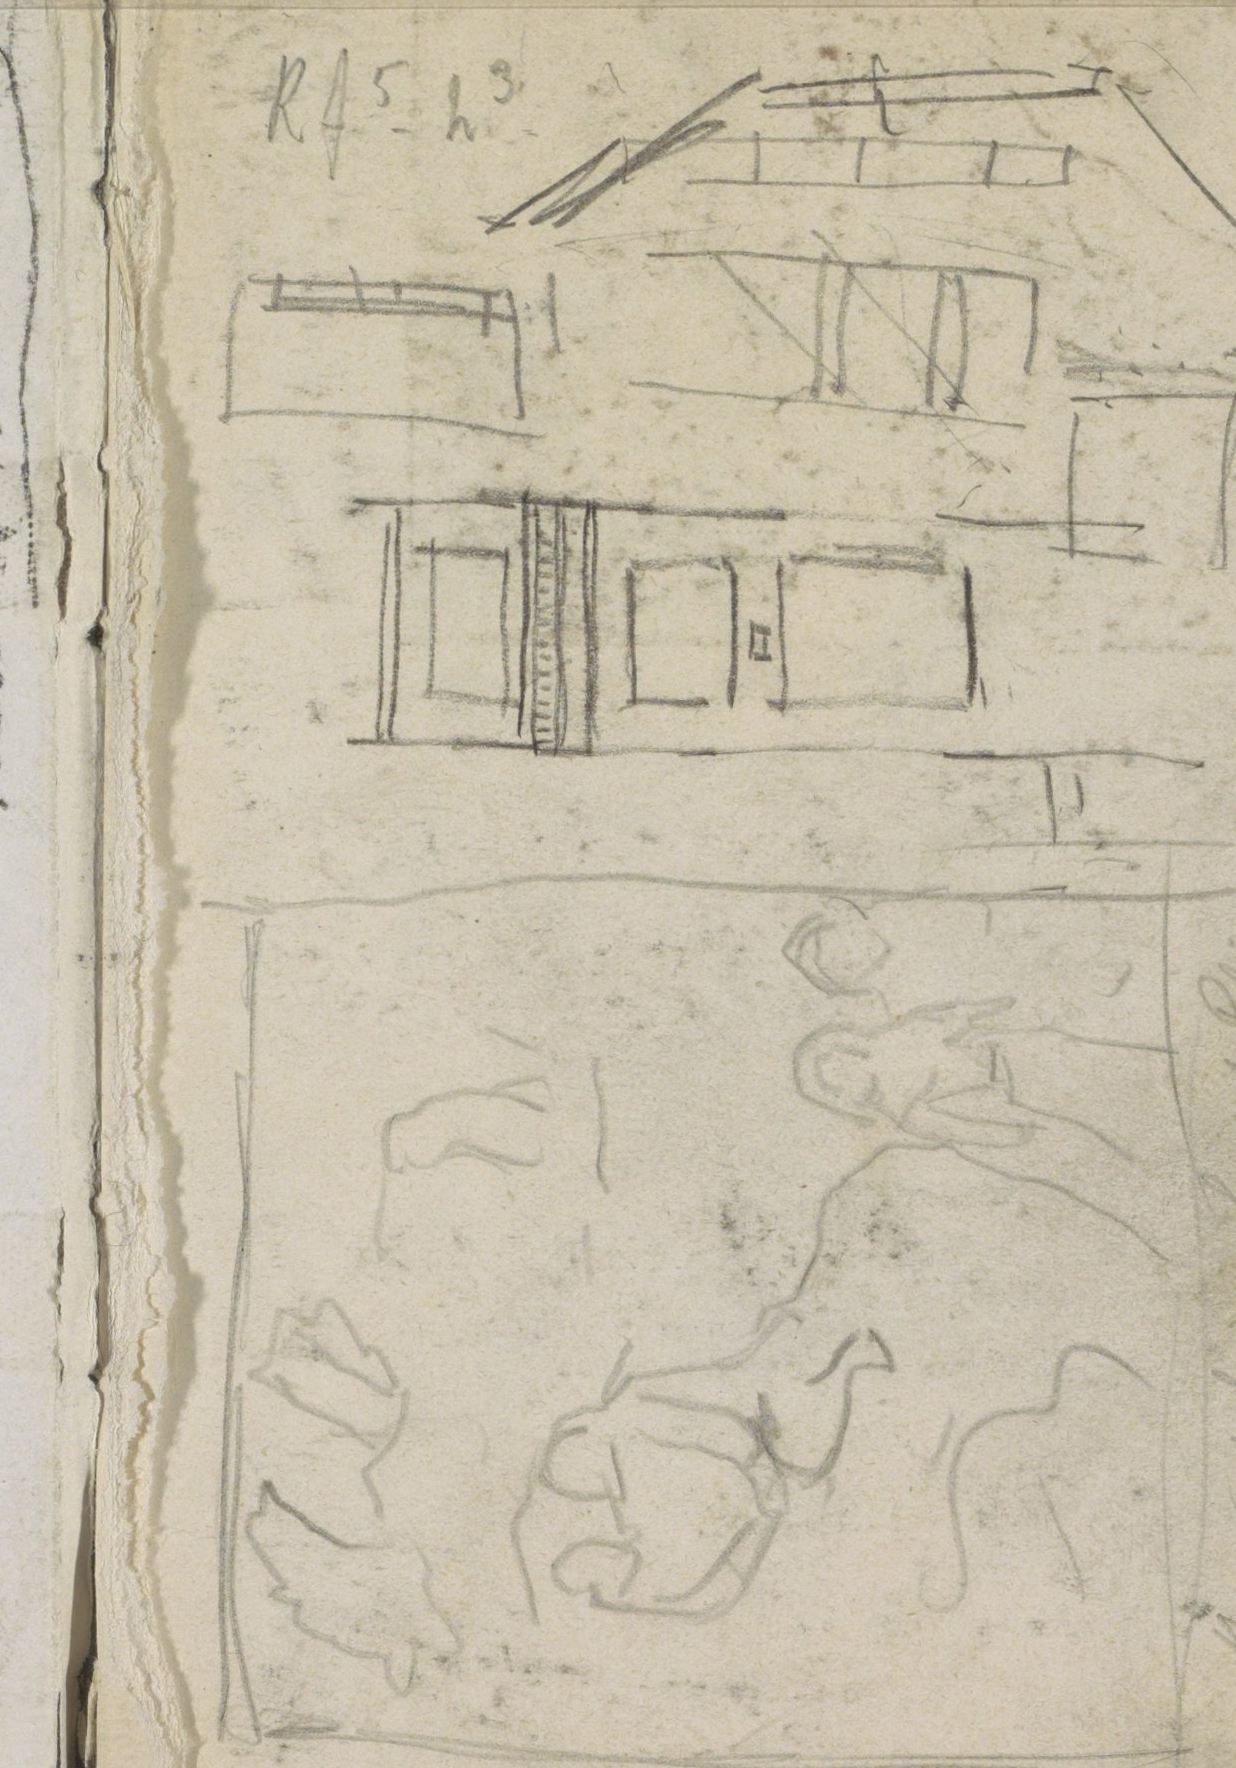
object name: sketchbook leaf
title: Architectuurstudies en een reliëf uit een huis aan het Leidsplein te Amsterdam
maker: george hendrik breitner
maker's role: draughtsman, painter, print maker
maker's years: 1857-1923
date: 1900-1923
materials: chalk, paper, pencil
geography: amsterdam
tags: piece of sculpture, reproduction of a piece of sculpture (+ stone ~ arts), architectural detail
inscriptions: annotation: ‘Steen in de huisjes Leidsche Plein’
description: Architectuurstudies en een reliëf, mogelijk een gevelsteen, van een huis aan het Leidsplein te Amsterdam. Pagina 2 uit een schetsboek met 39 bladen.